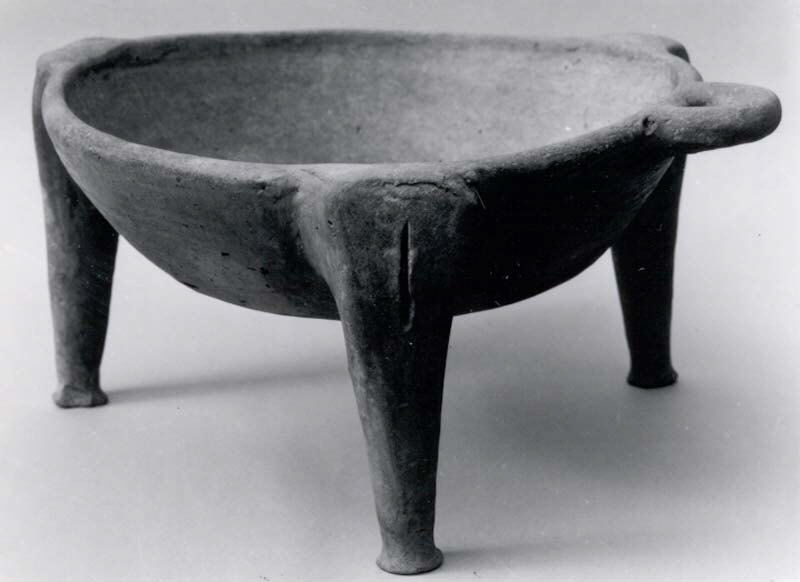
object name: bowl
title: Tripod bowl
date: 2000-1001 BCE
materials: ceramic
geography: iran